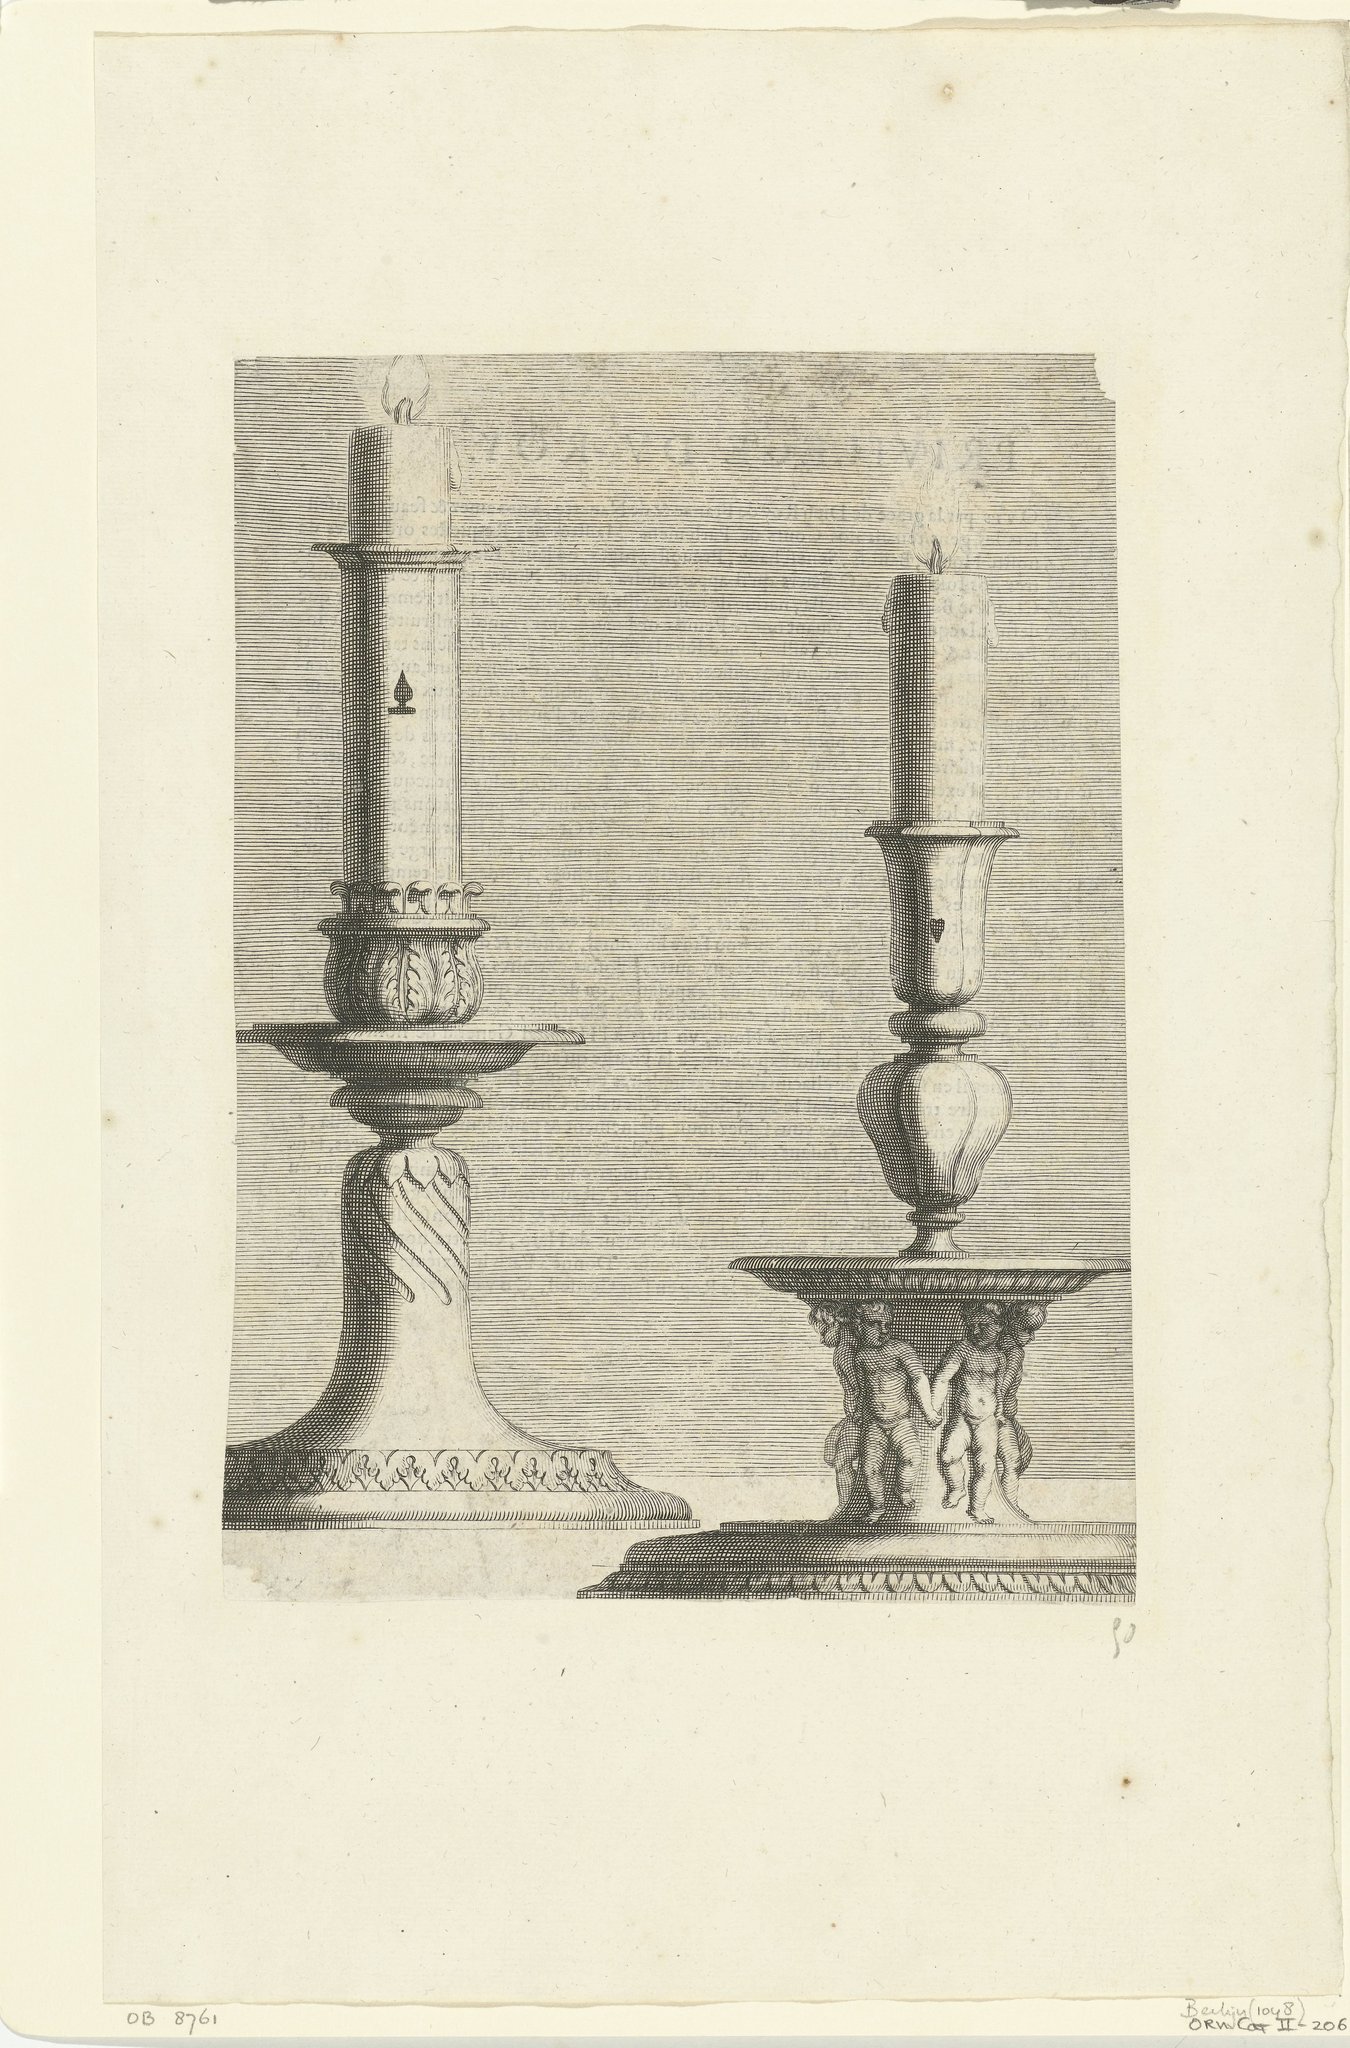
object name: ornament print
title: Second Livre de Vases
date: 1667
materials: paper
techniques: engraving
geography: france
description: Het voetstuk van de kandelaar rechts is gedecoreerd met naakte dansende kinderen. Blad 50 uit serie van 25 bladen, genummerd: II (voorheen 26), 27-50. Deze serie werd voorafgegaan door de serie Livre de Vases, bestaande uit 24 bladen, waarin de nummering begon.